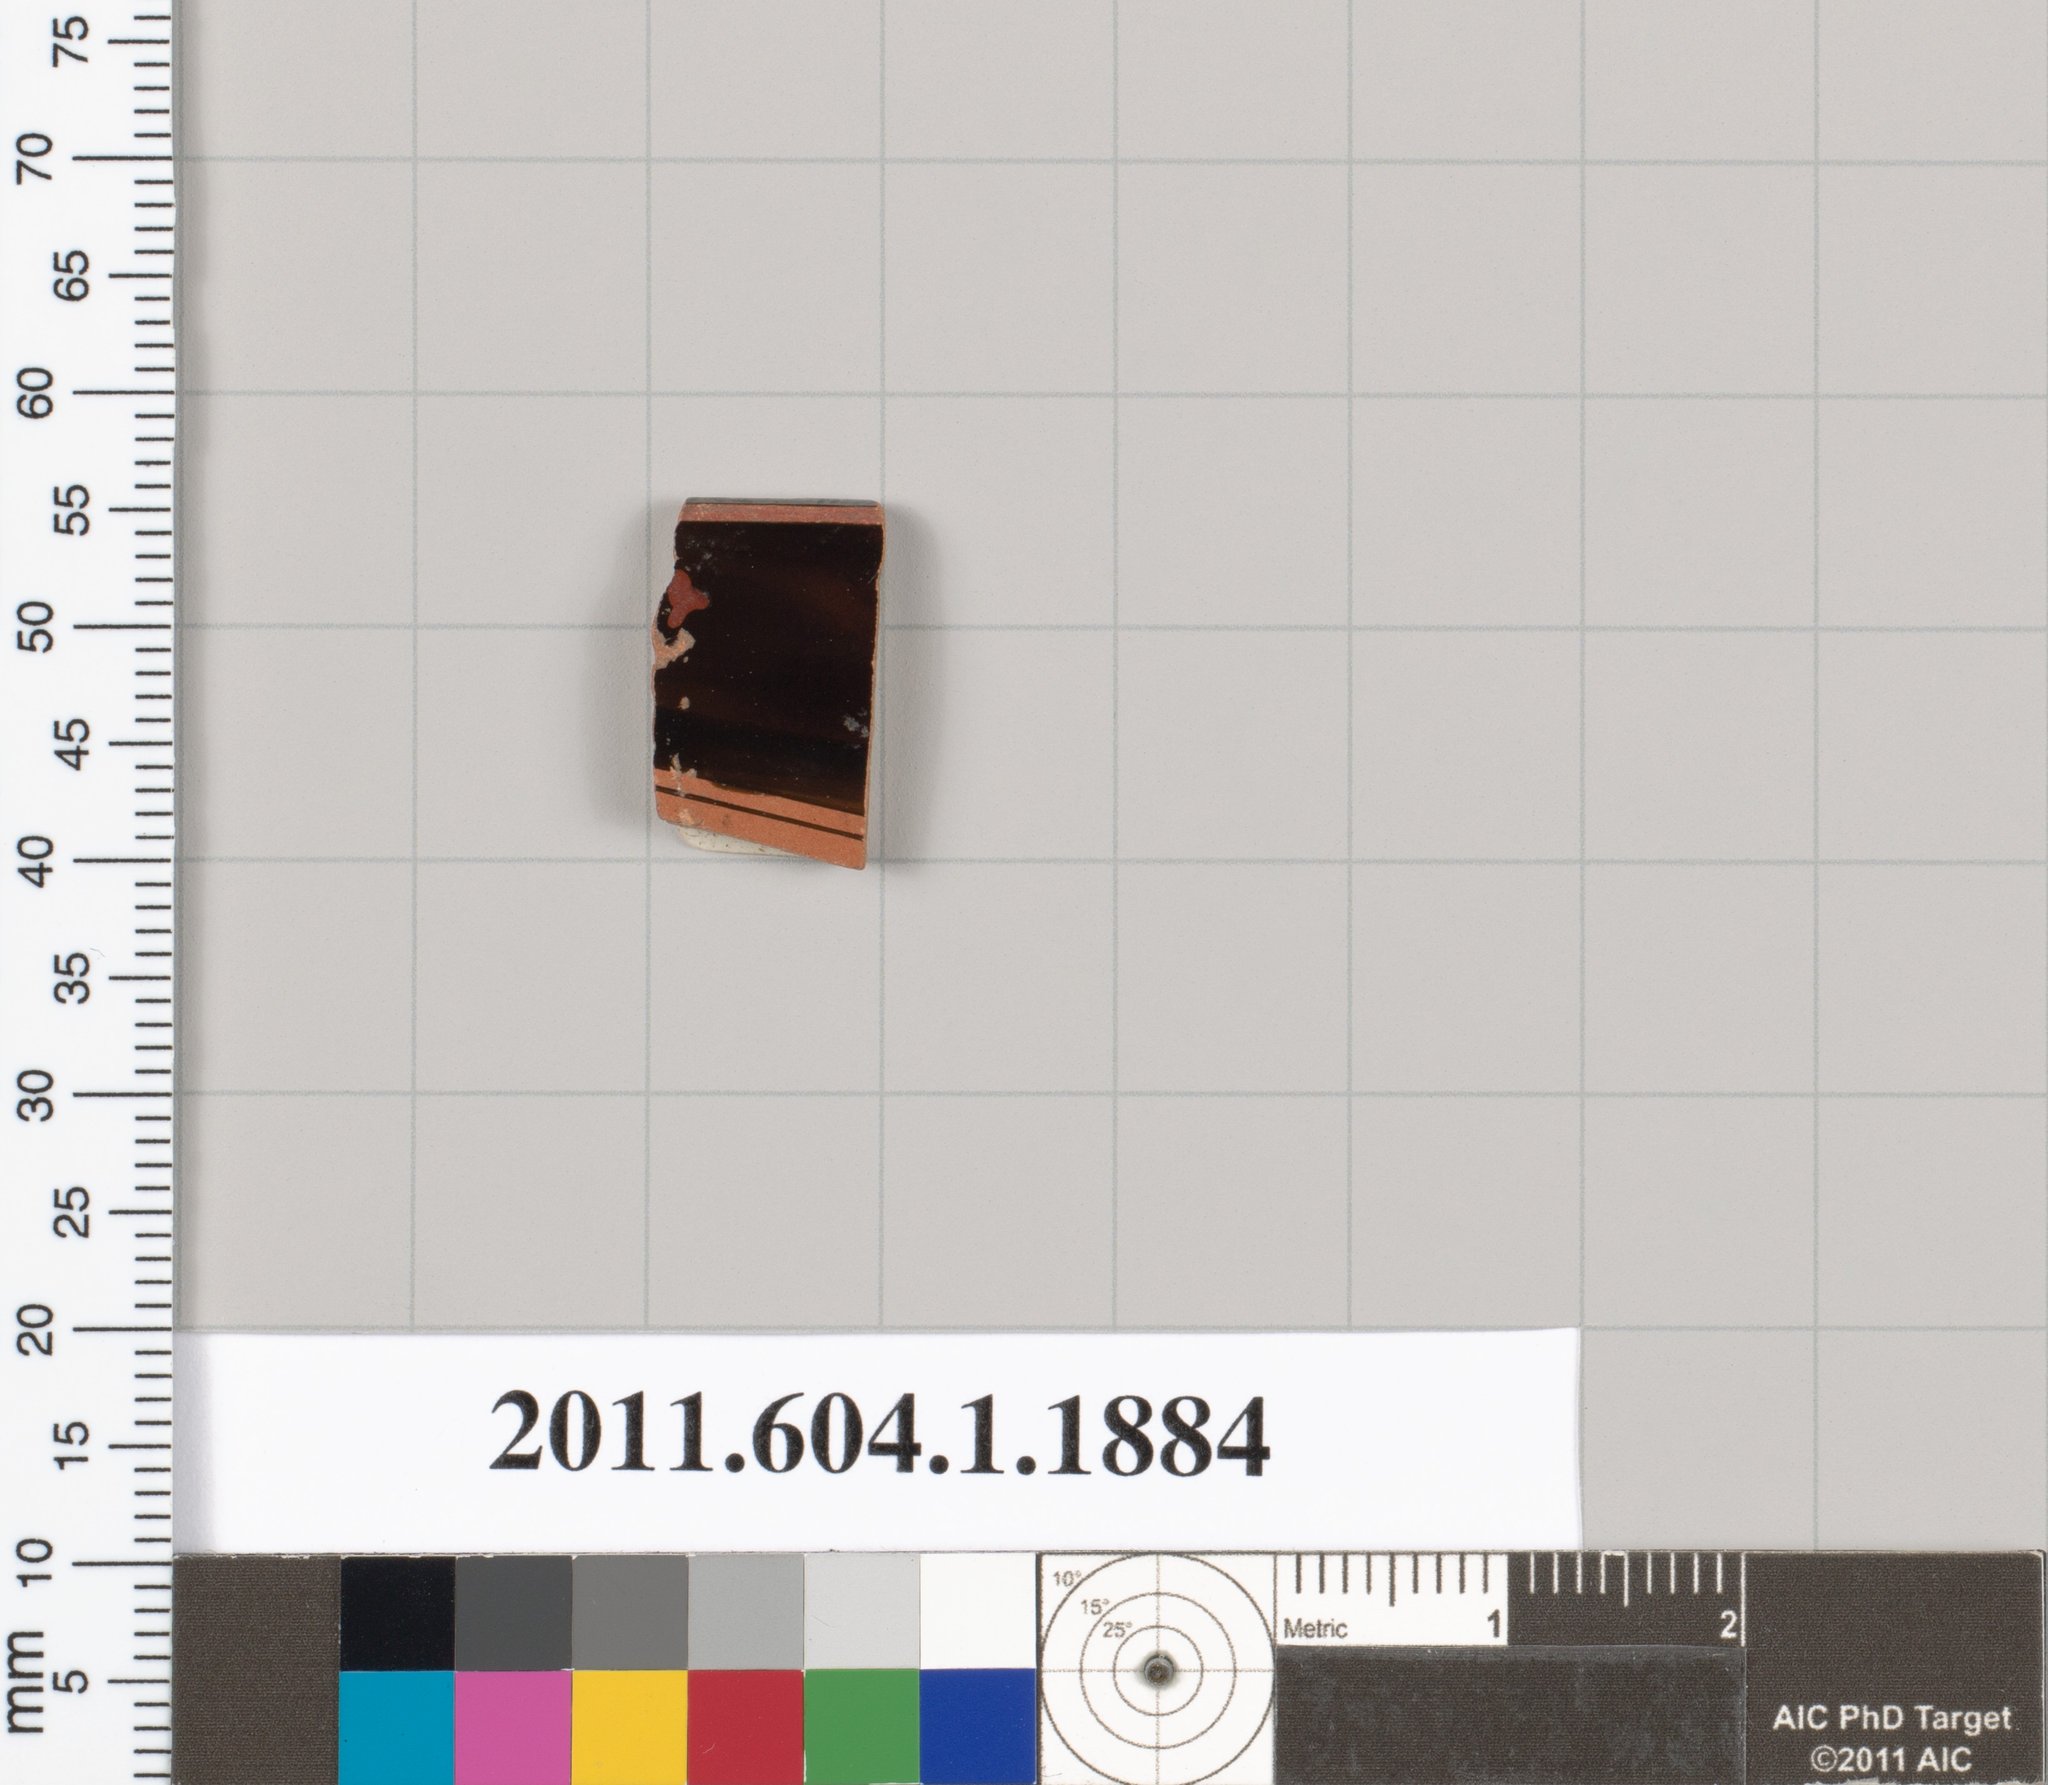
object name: kylix fragment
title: Terracotta rim fragment of a kylix (drinking cup)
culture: greek, attic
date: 475-451 BCE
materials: terracotta